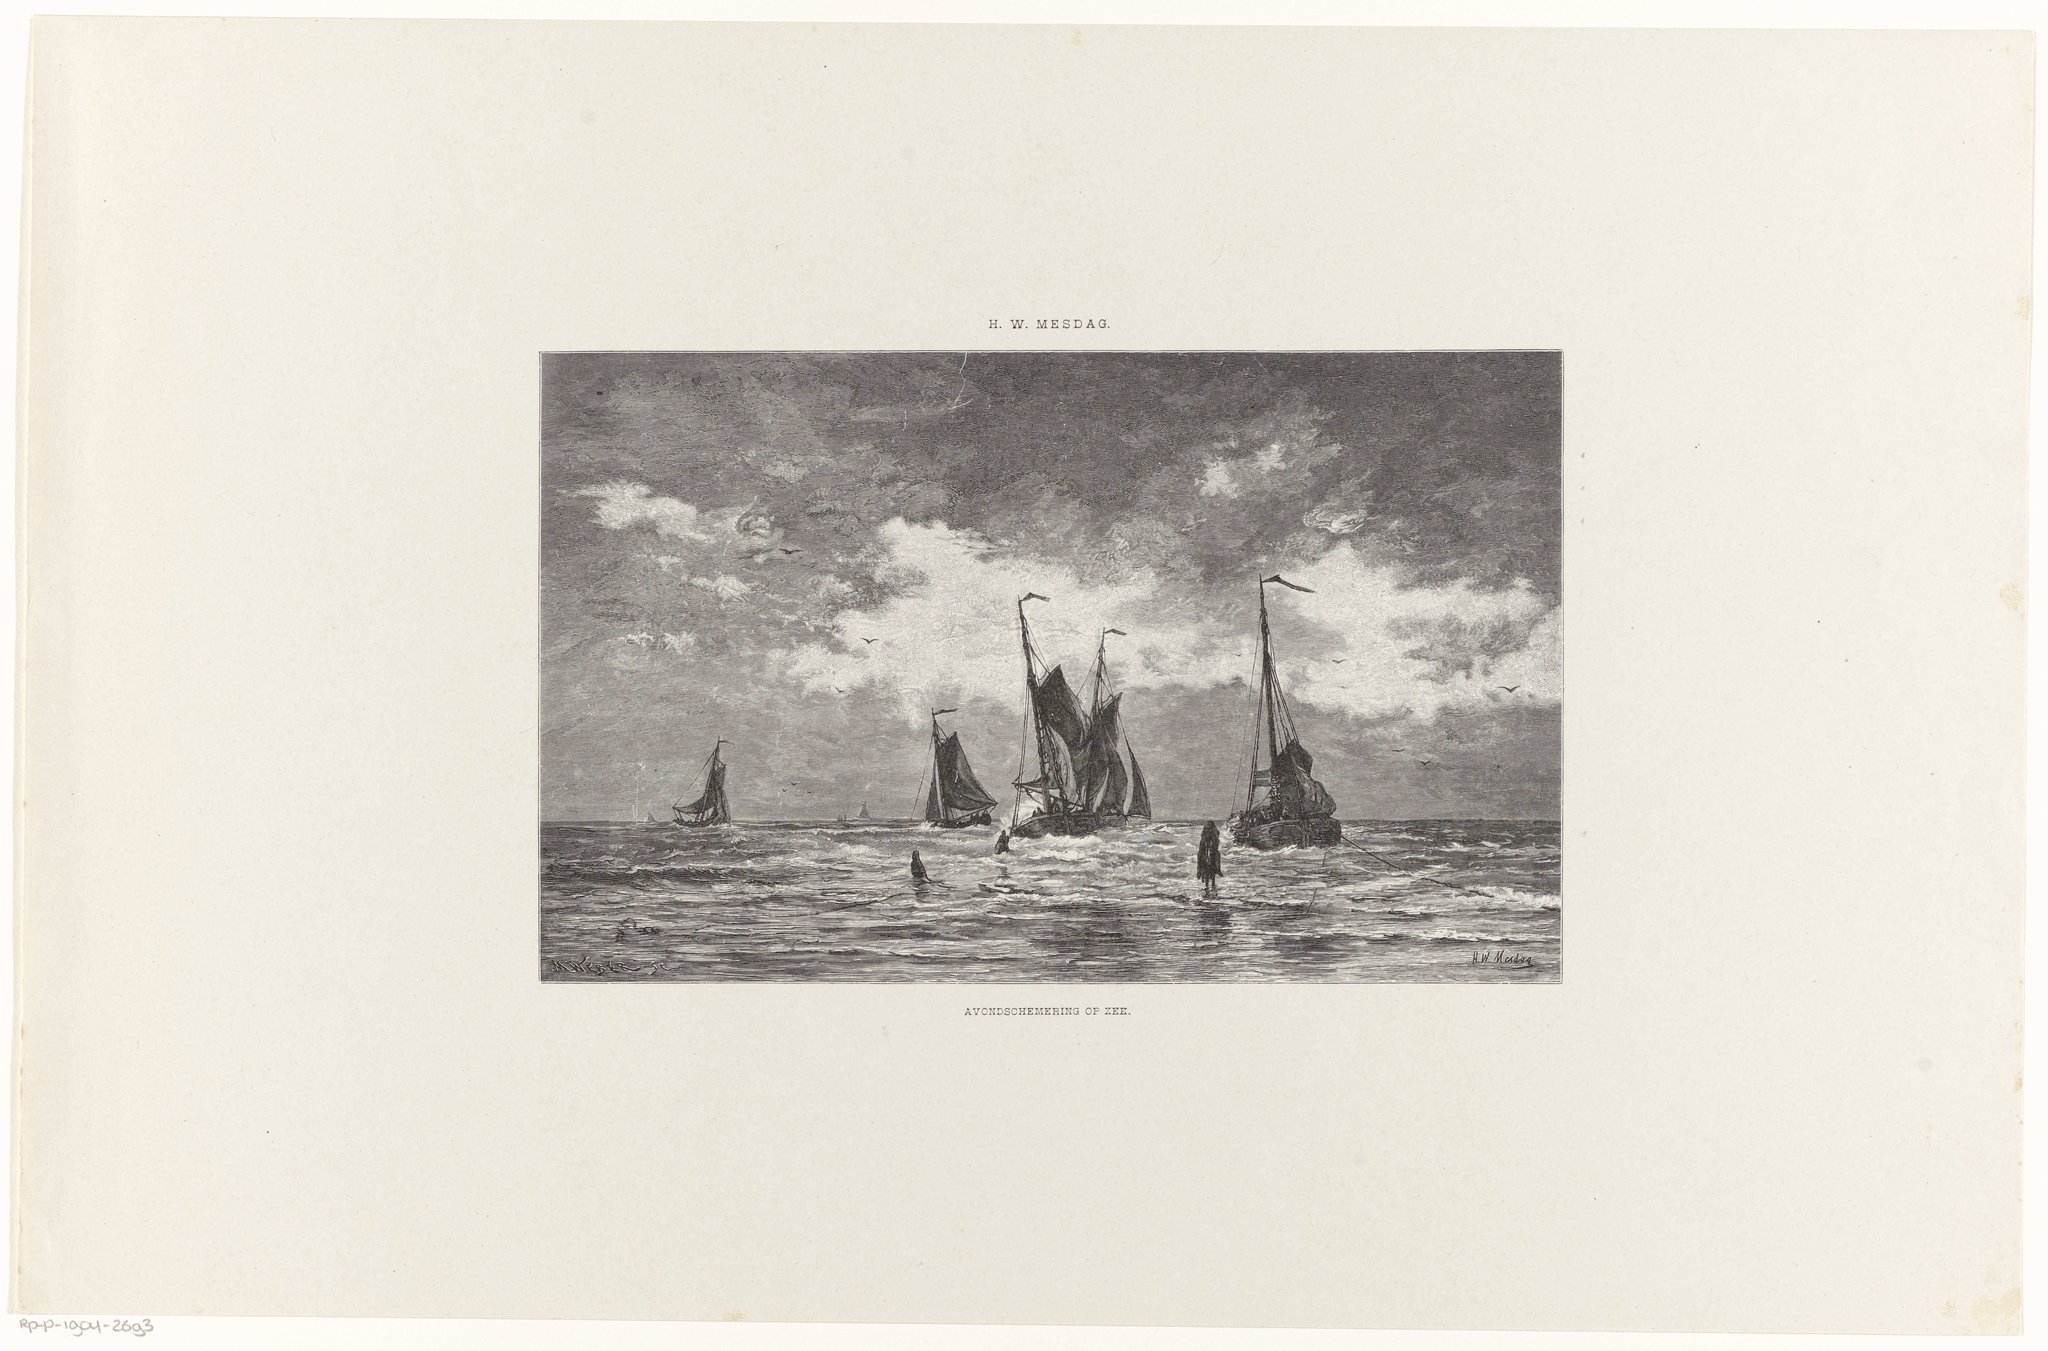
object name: print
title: Avondschemering op zee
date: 1850-1899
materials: paper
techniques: engraving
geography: netherlands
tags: dusk, evening twilight, ships (in general), sea (seascape)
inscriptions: collector's mark: Lugt 2228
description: In de avondschemering varen schepen en lopen figuren door de branding van de zee.